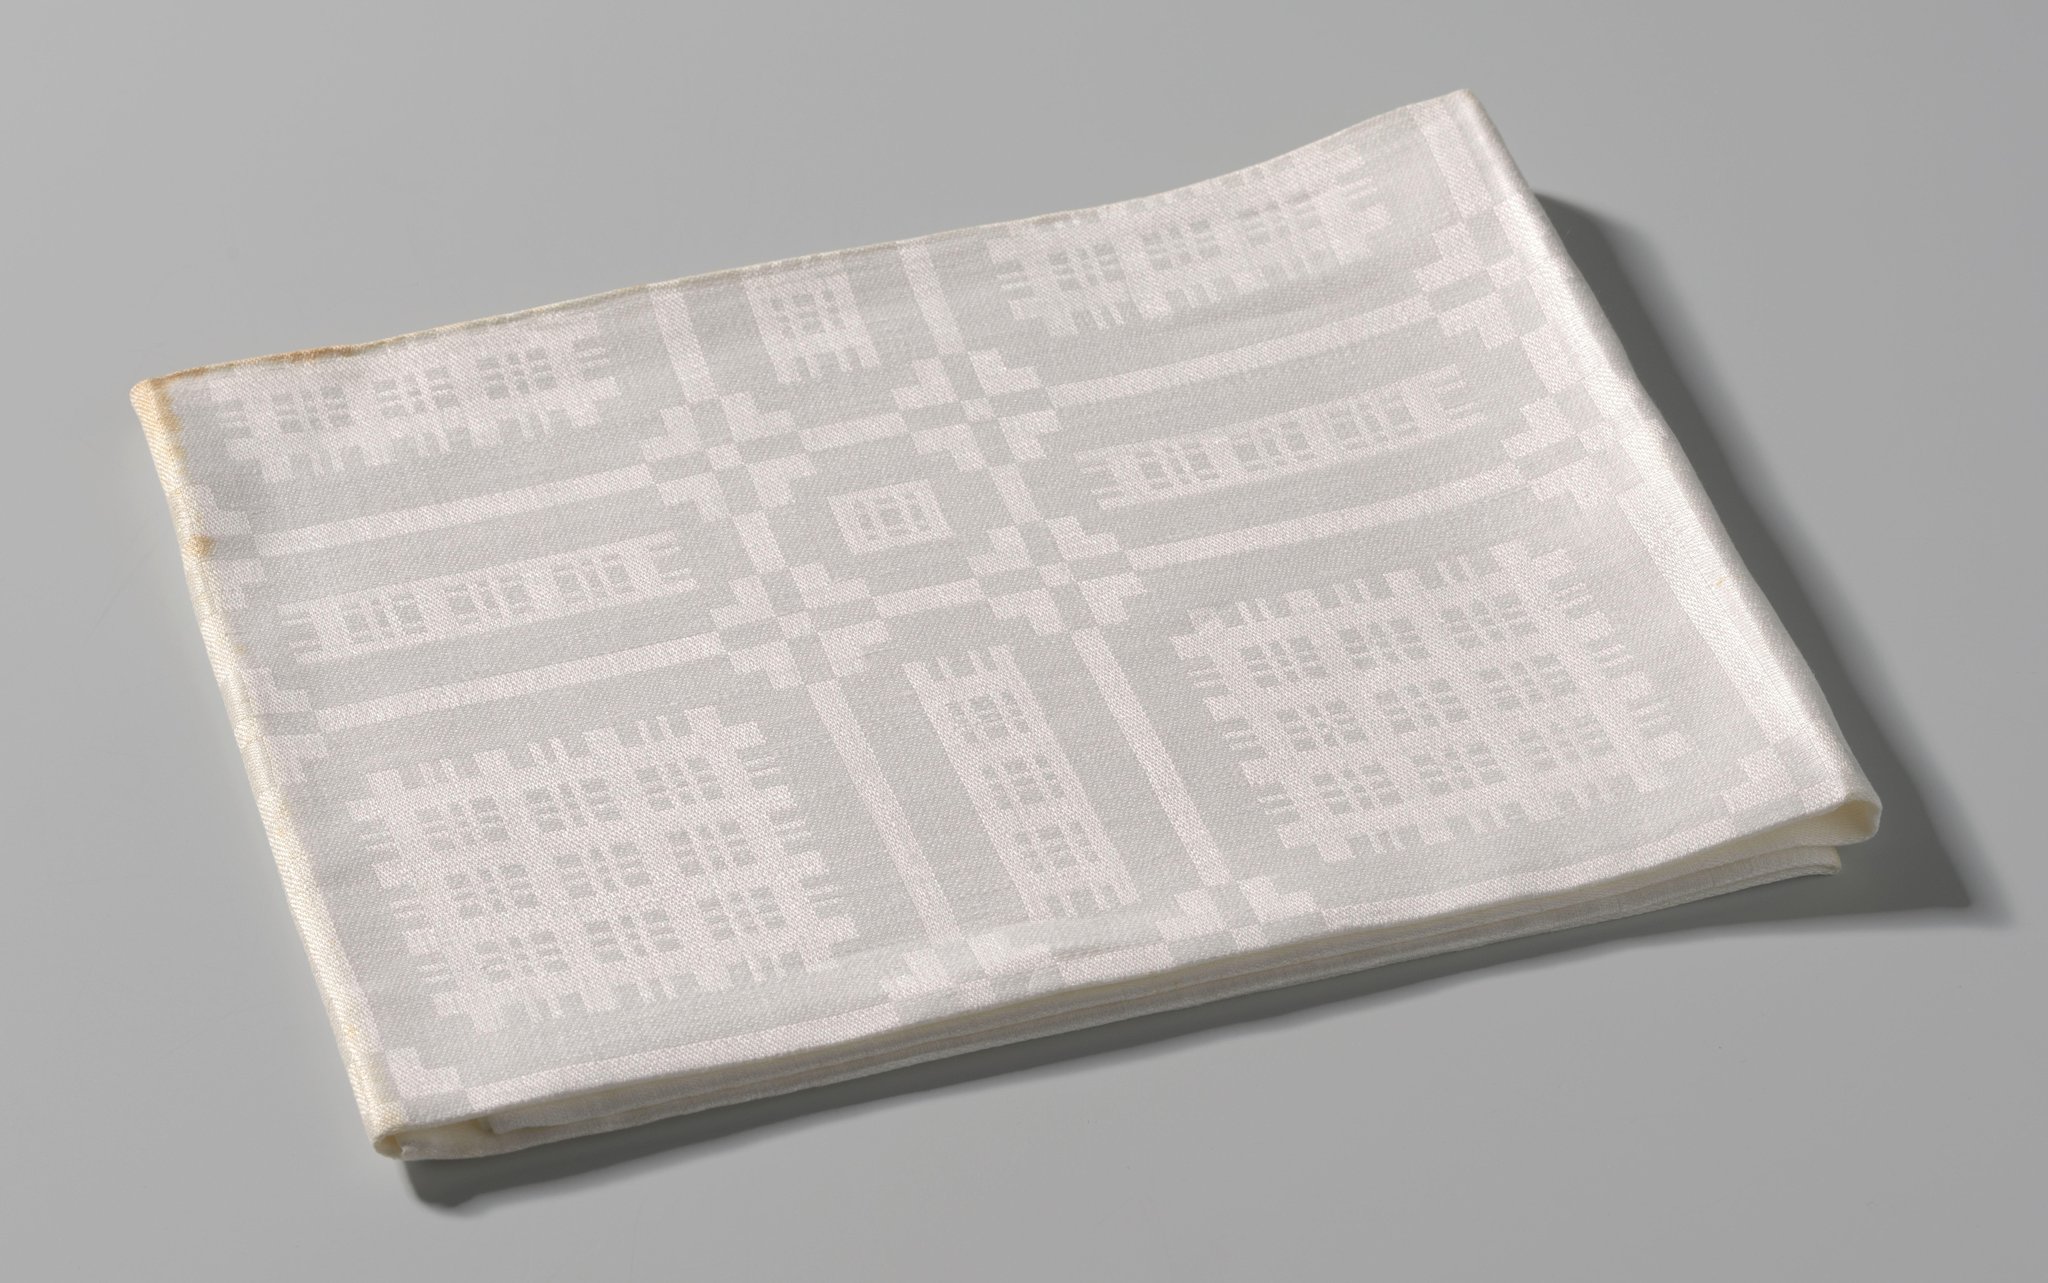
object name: napkin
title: Servet van linnen met pellenpatroon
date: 1700-1799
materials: linen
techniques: peeled fabric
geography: netherlands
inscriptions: : ‘WH 2oonl’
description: Wit linnen servet met een pellenpatroon.